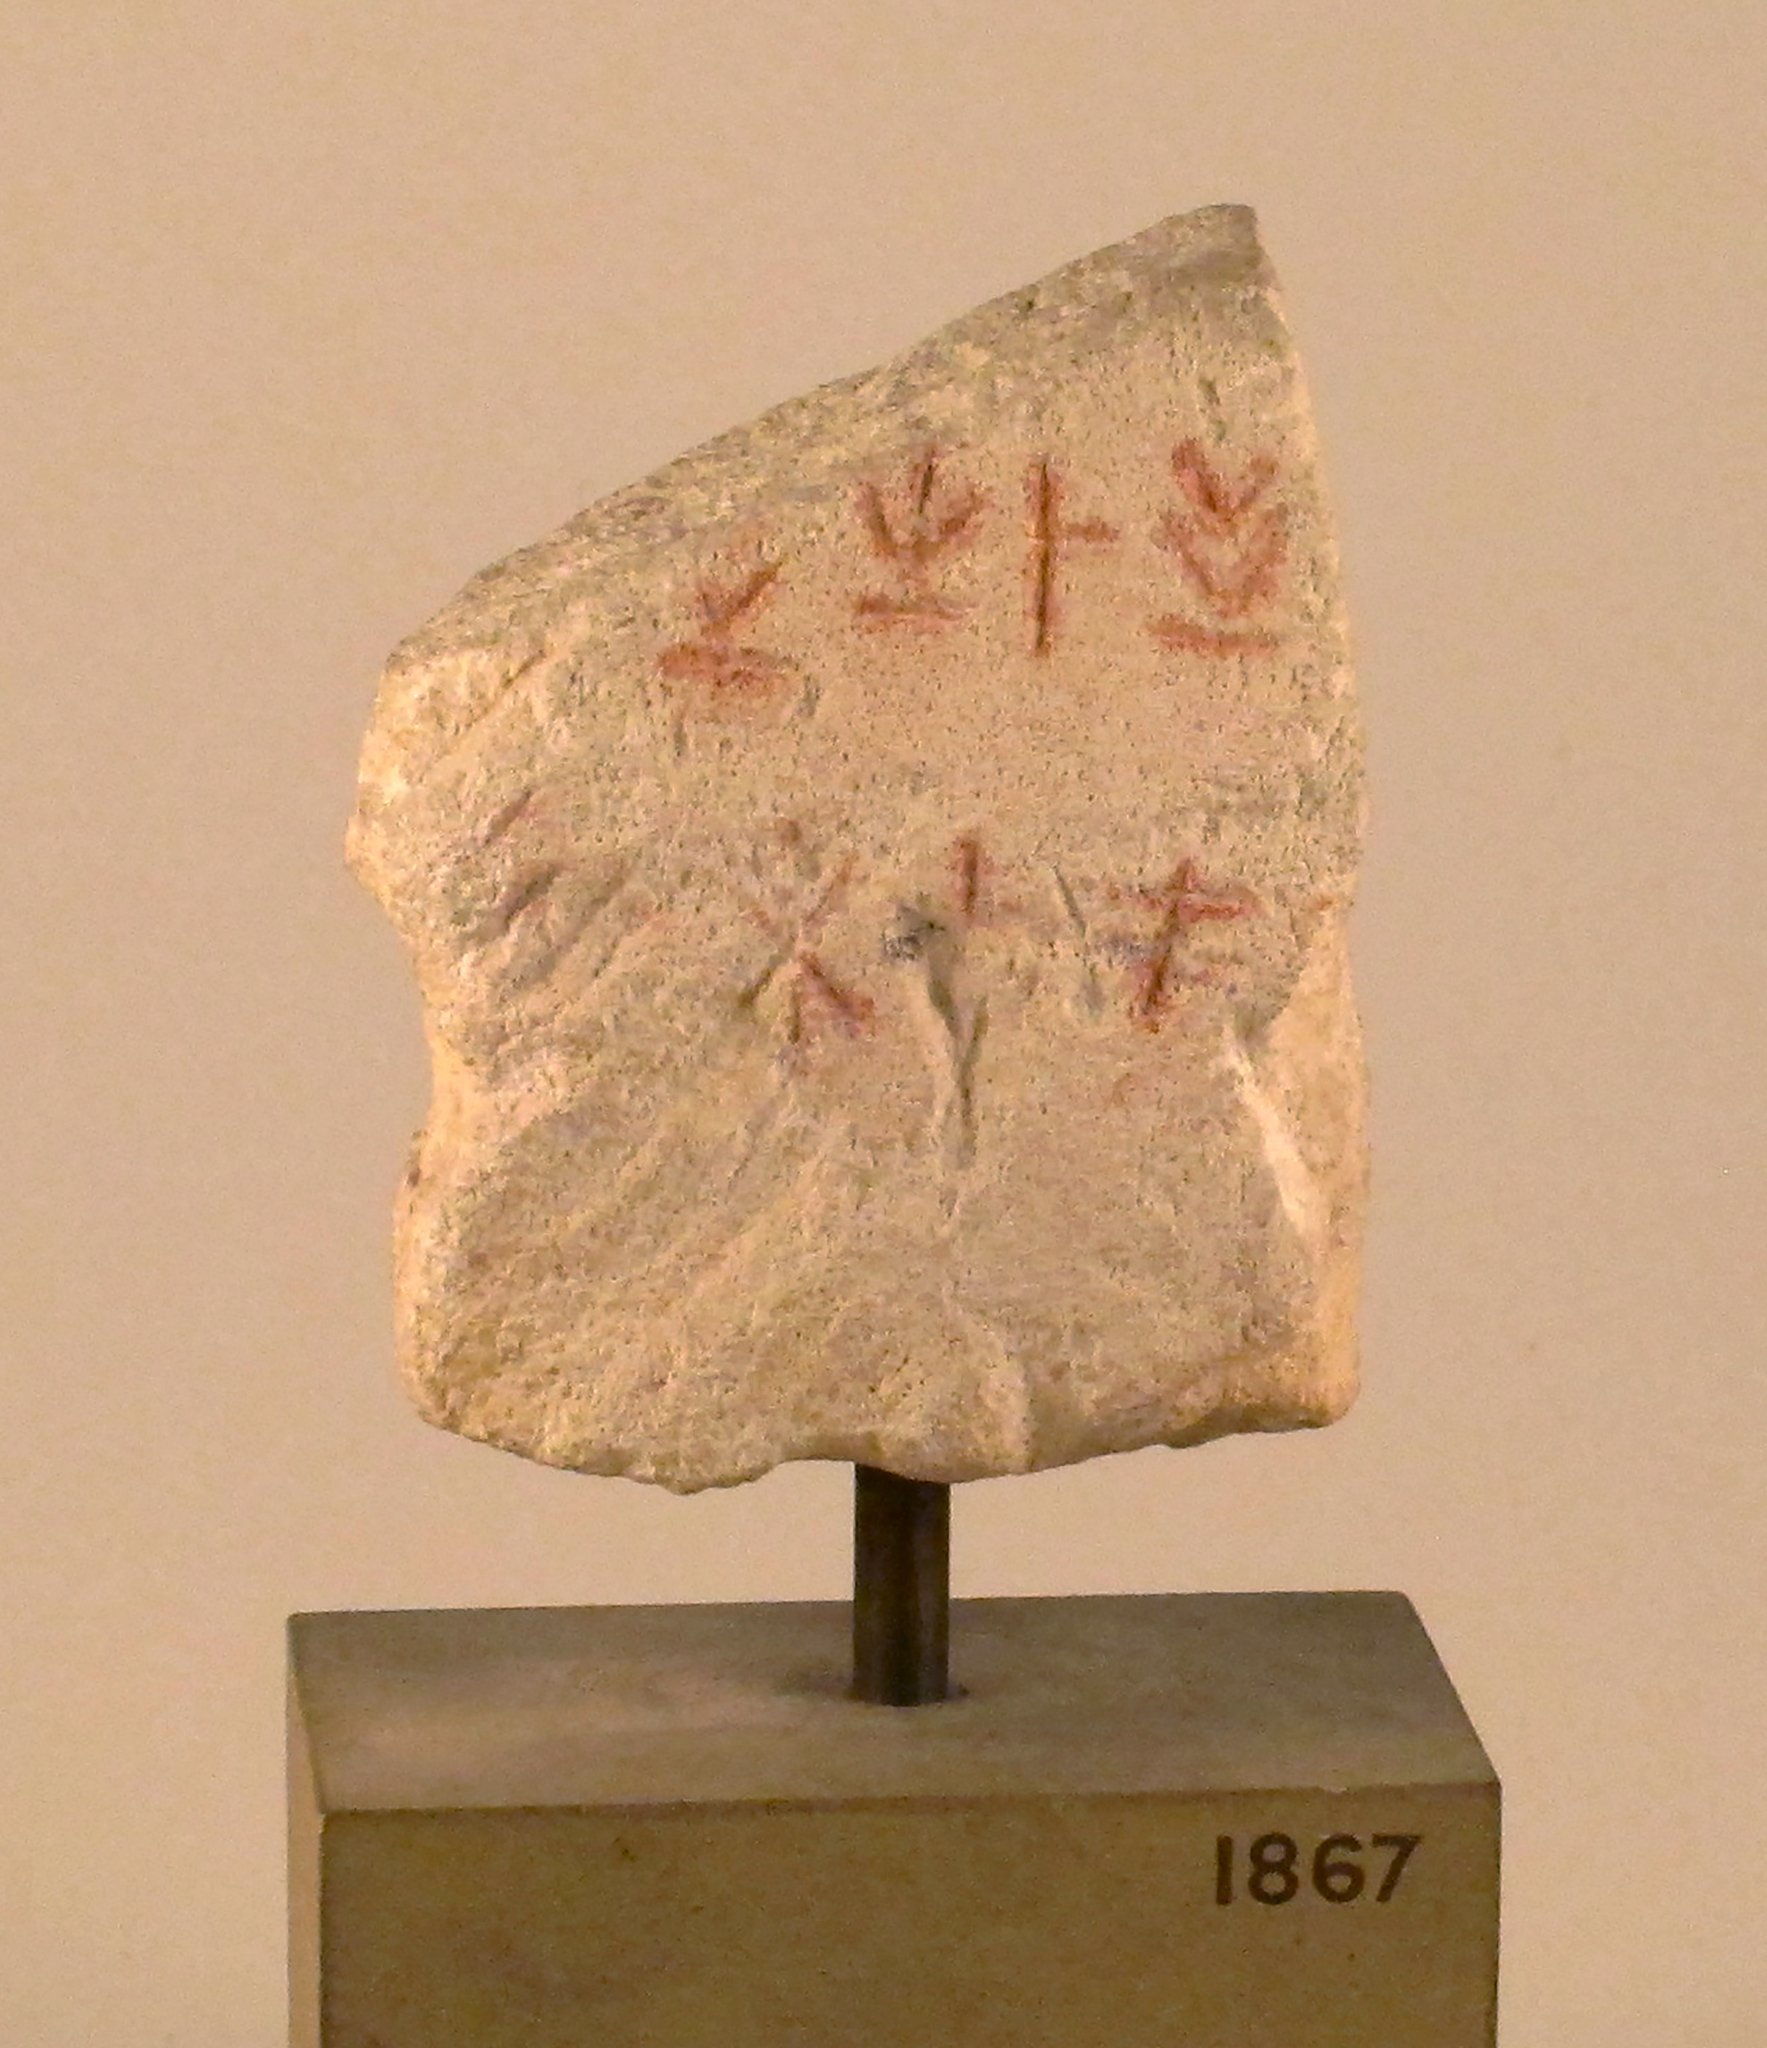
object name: chest or trough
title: Limestone inscribed fragment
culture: cypriot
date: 3900 BCE-100 CE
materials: stone